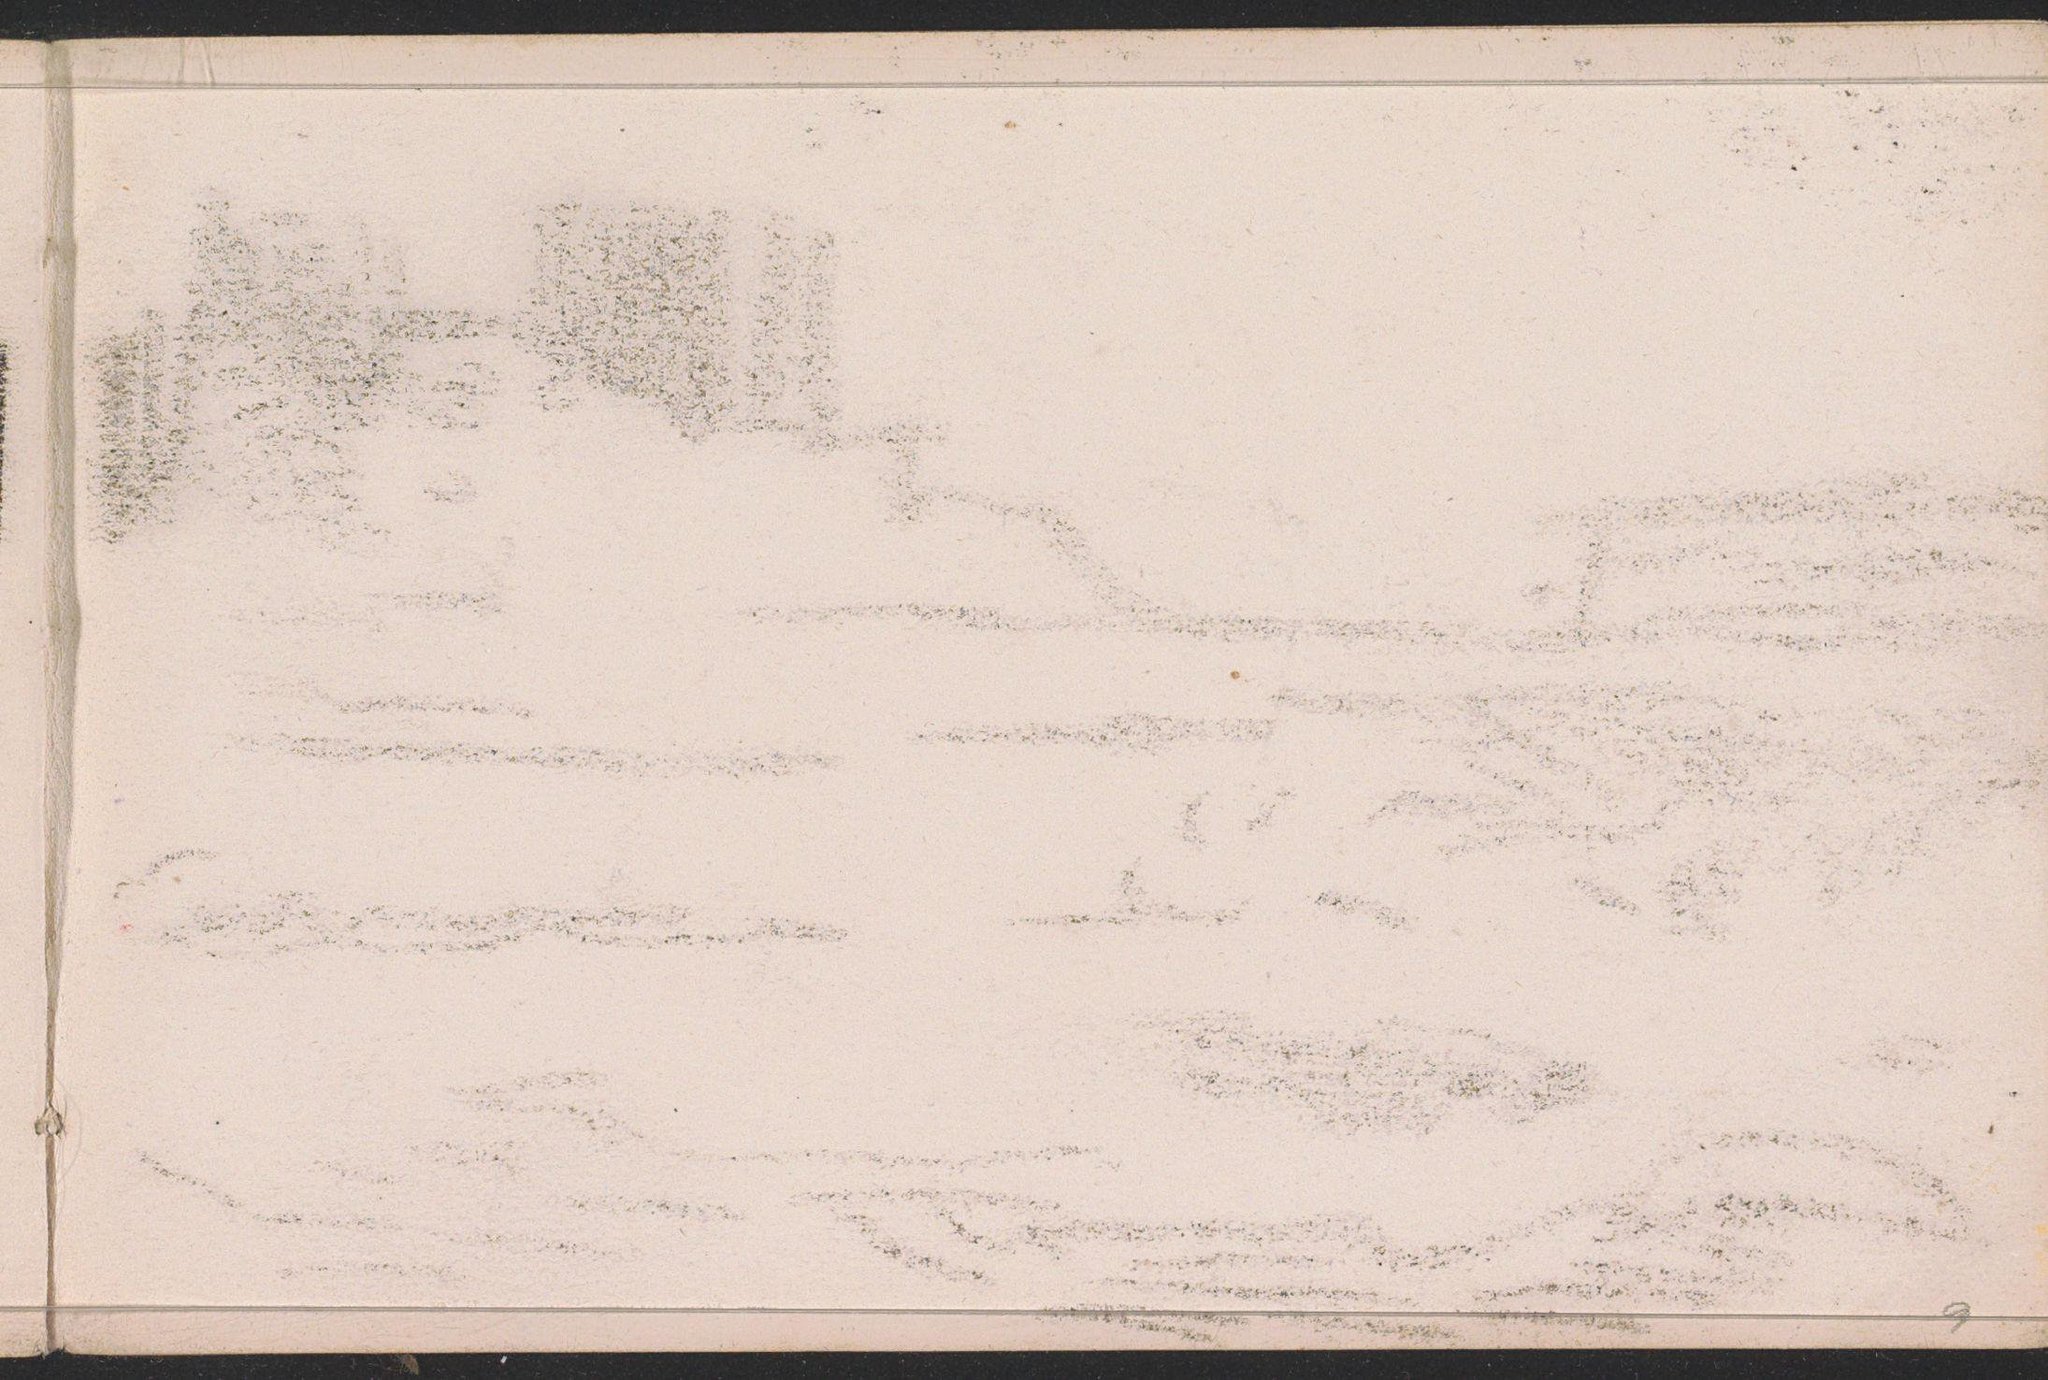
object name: sketchbook leaf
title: Abklatsch van de krijttekening op blad 8 verso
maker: isaac israels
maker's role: draughtsman, painter, print maker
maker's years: 1865-1934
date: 1875-1934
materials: paper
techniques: printmaking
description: Blad 9 recto uit schetsboek LIII met 10 bladen.